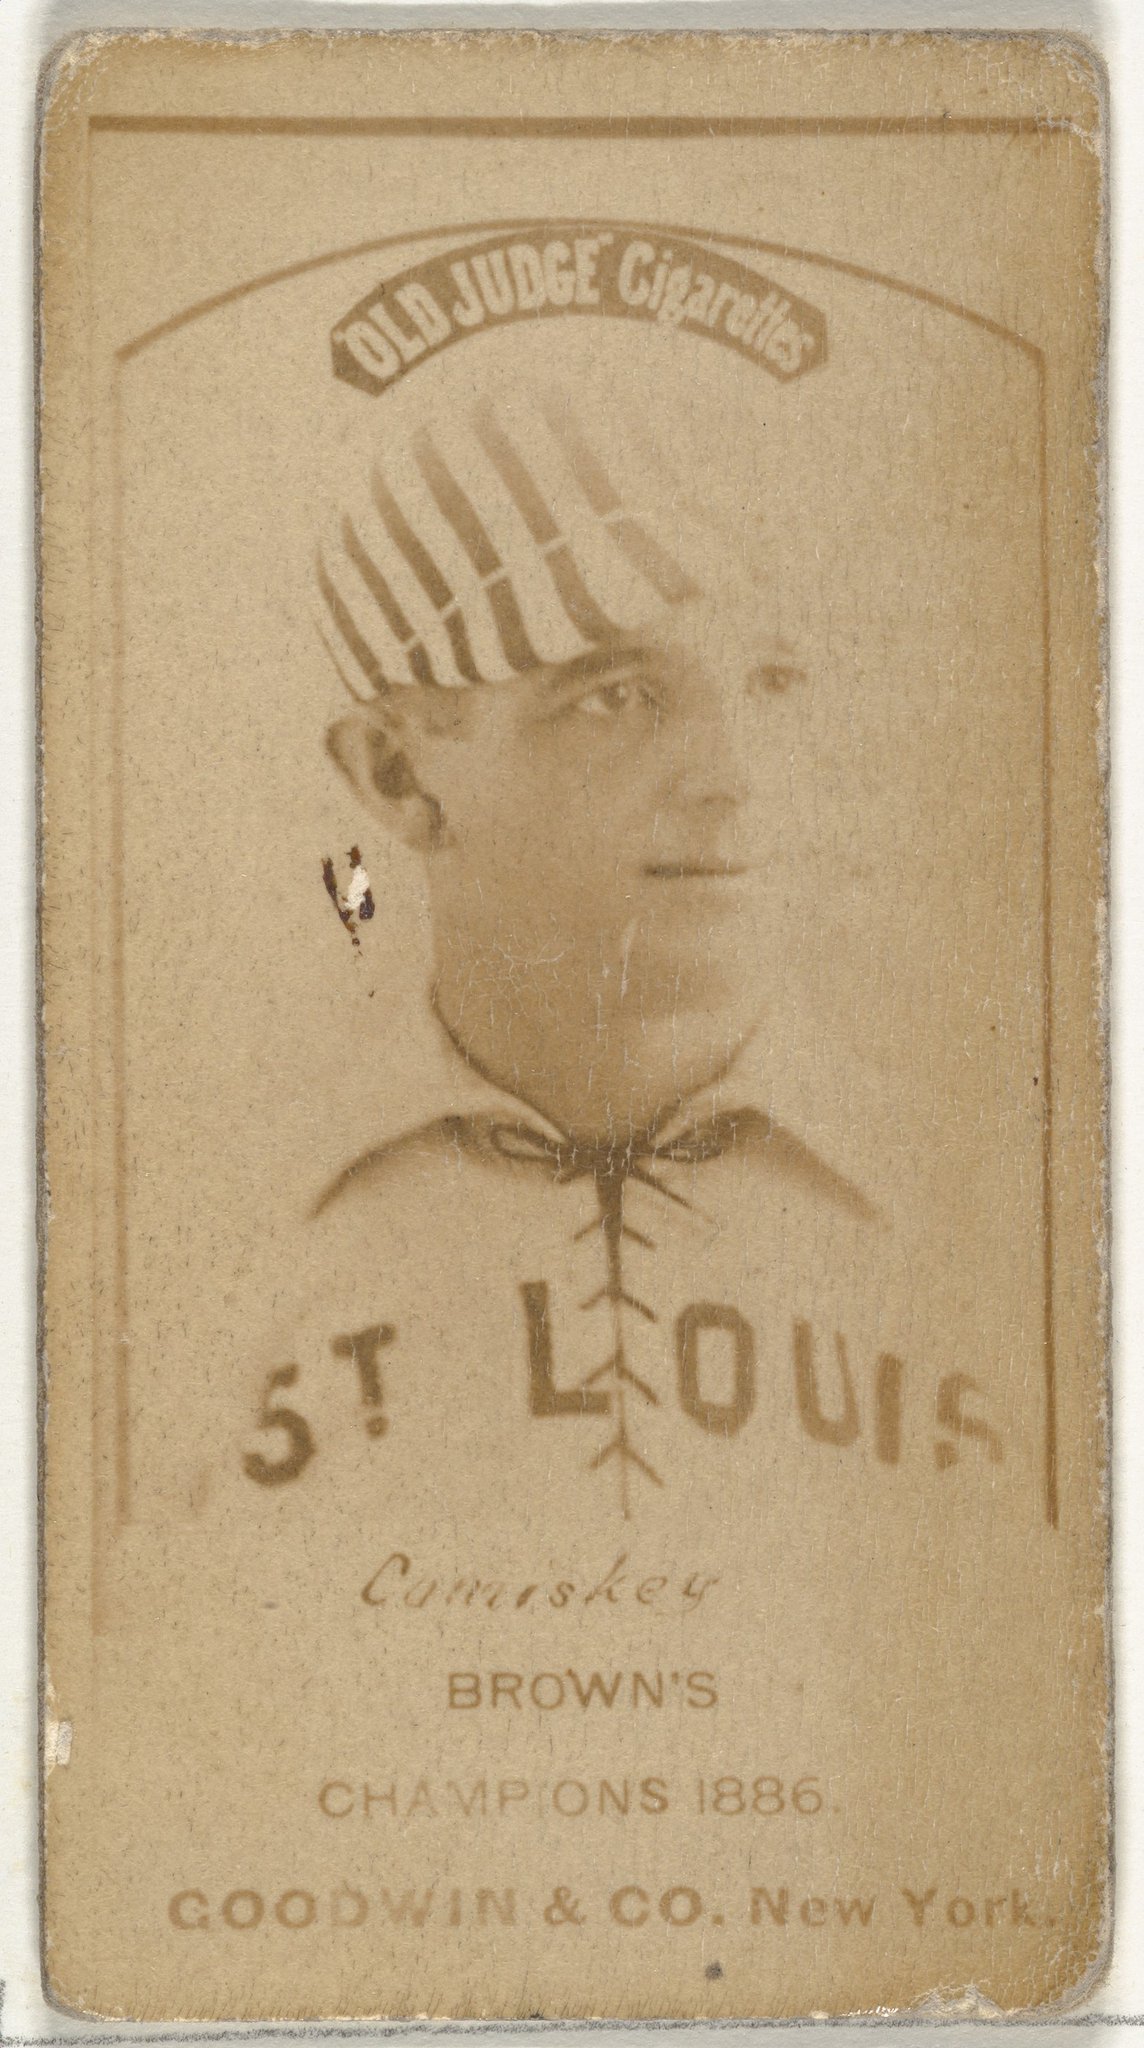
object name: baseball card, photograph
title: Charles Albert "The Old Roman" Comiskey, 1st Base and Manager, St. Louis Browns, from the Old Judge series (N172) for Old Judge Cigarettes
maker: goodwin & company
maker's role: publisher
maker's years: 1850-1950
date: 1886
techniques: albumen silver print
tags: men,portraits,baseball,athletes